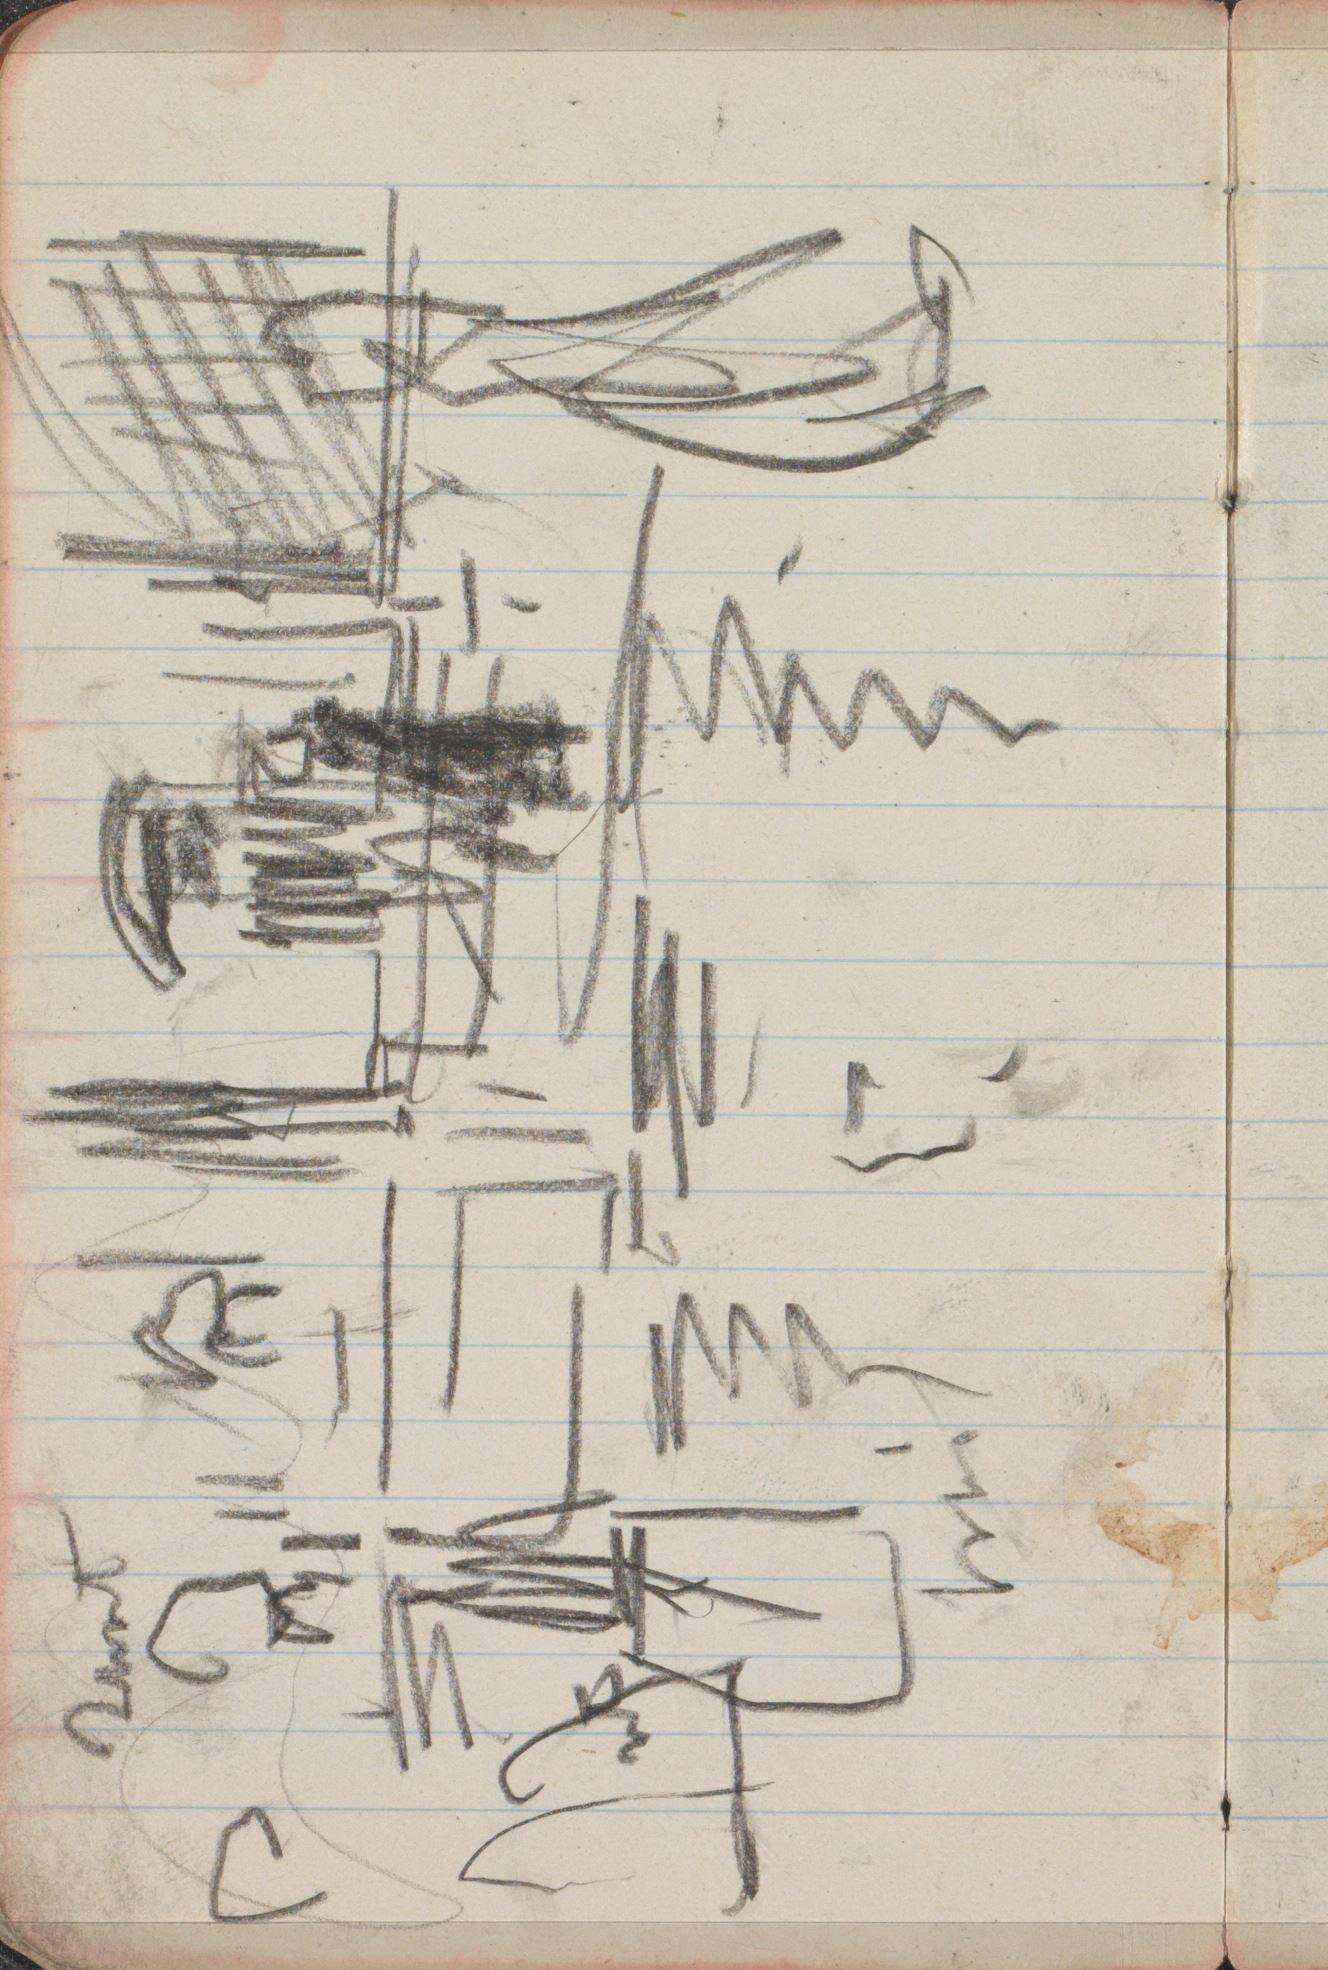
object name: sketchbook leaf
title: Figuren op de Nieuwendijk in Amsterdam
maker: george hendrik breitner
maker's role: draughtsman, painter, print maker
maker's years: 1857-1923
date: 1892-1900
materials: chalk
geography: amsterdam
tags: civic architecture; edifices; dwellings, street (+ city(-scape) with figures, staffage), shop-window, show-window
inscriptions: kleurnotitie, handgeschreven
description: Pagina 23 uit een schetsboek met 38 bladen.